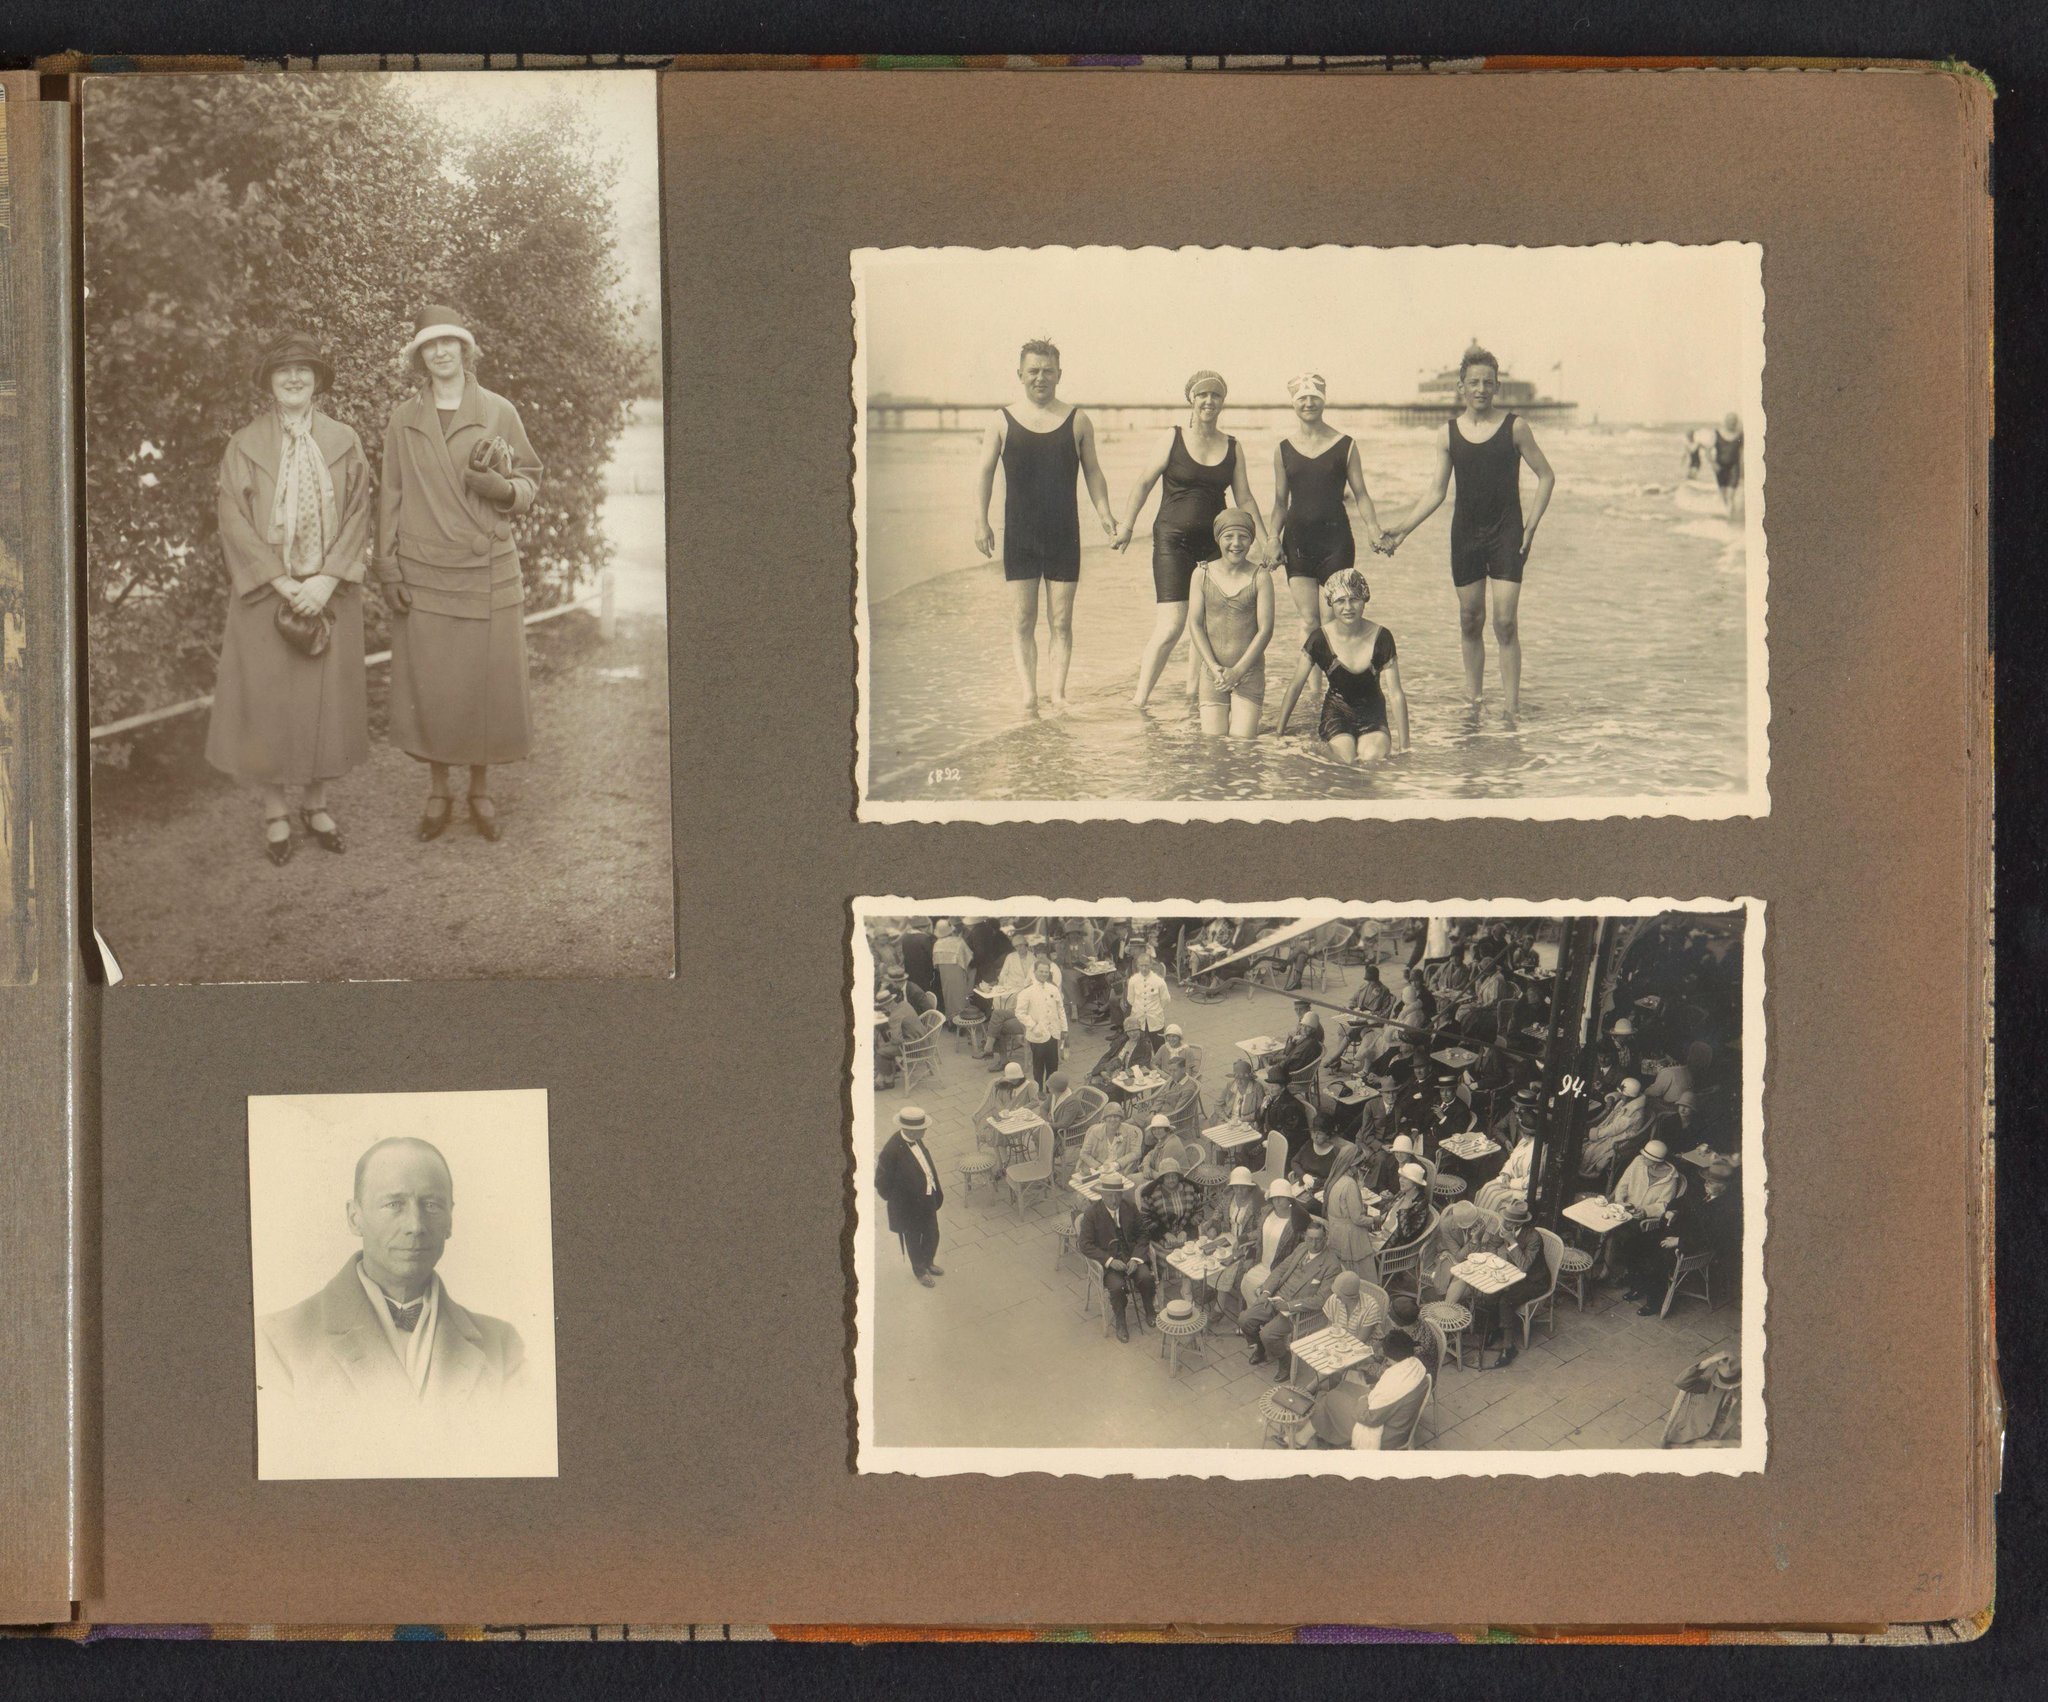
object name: photograph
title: Gezelschappen en portret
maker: Anonymous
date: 1900-1925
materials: cardboard, photographic support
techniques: gelatin silver print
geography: netherlands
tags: beach (as place of recreation), adult woman, adult man, pavement, terrace in front of inn or restaurant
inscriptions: number: ‘6822’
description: Albumblad met foto's van twee vrouwen poserend bij een struik, een gezelschap in badkleding aan het Scheveningse strand en gasten op het terras van 'Café-Restaurant du Boulevard' aldaar. Ook een portret van een onbekende man. Onderdeel van Fotoalbum van een onbekende Nederlandse familie met connecties in Suriname en Nederlands-Indië (2).